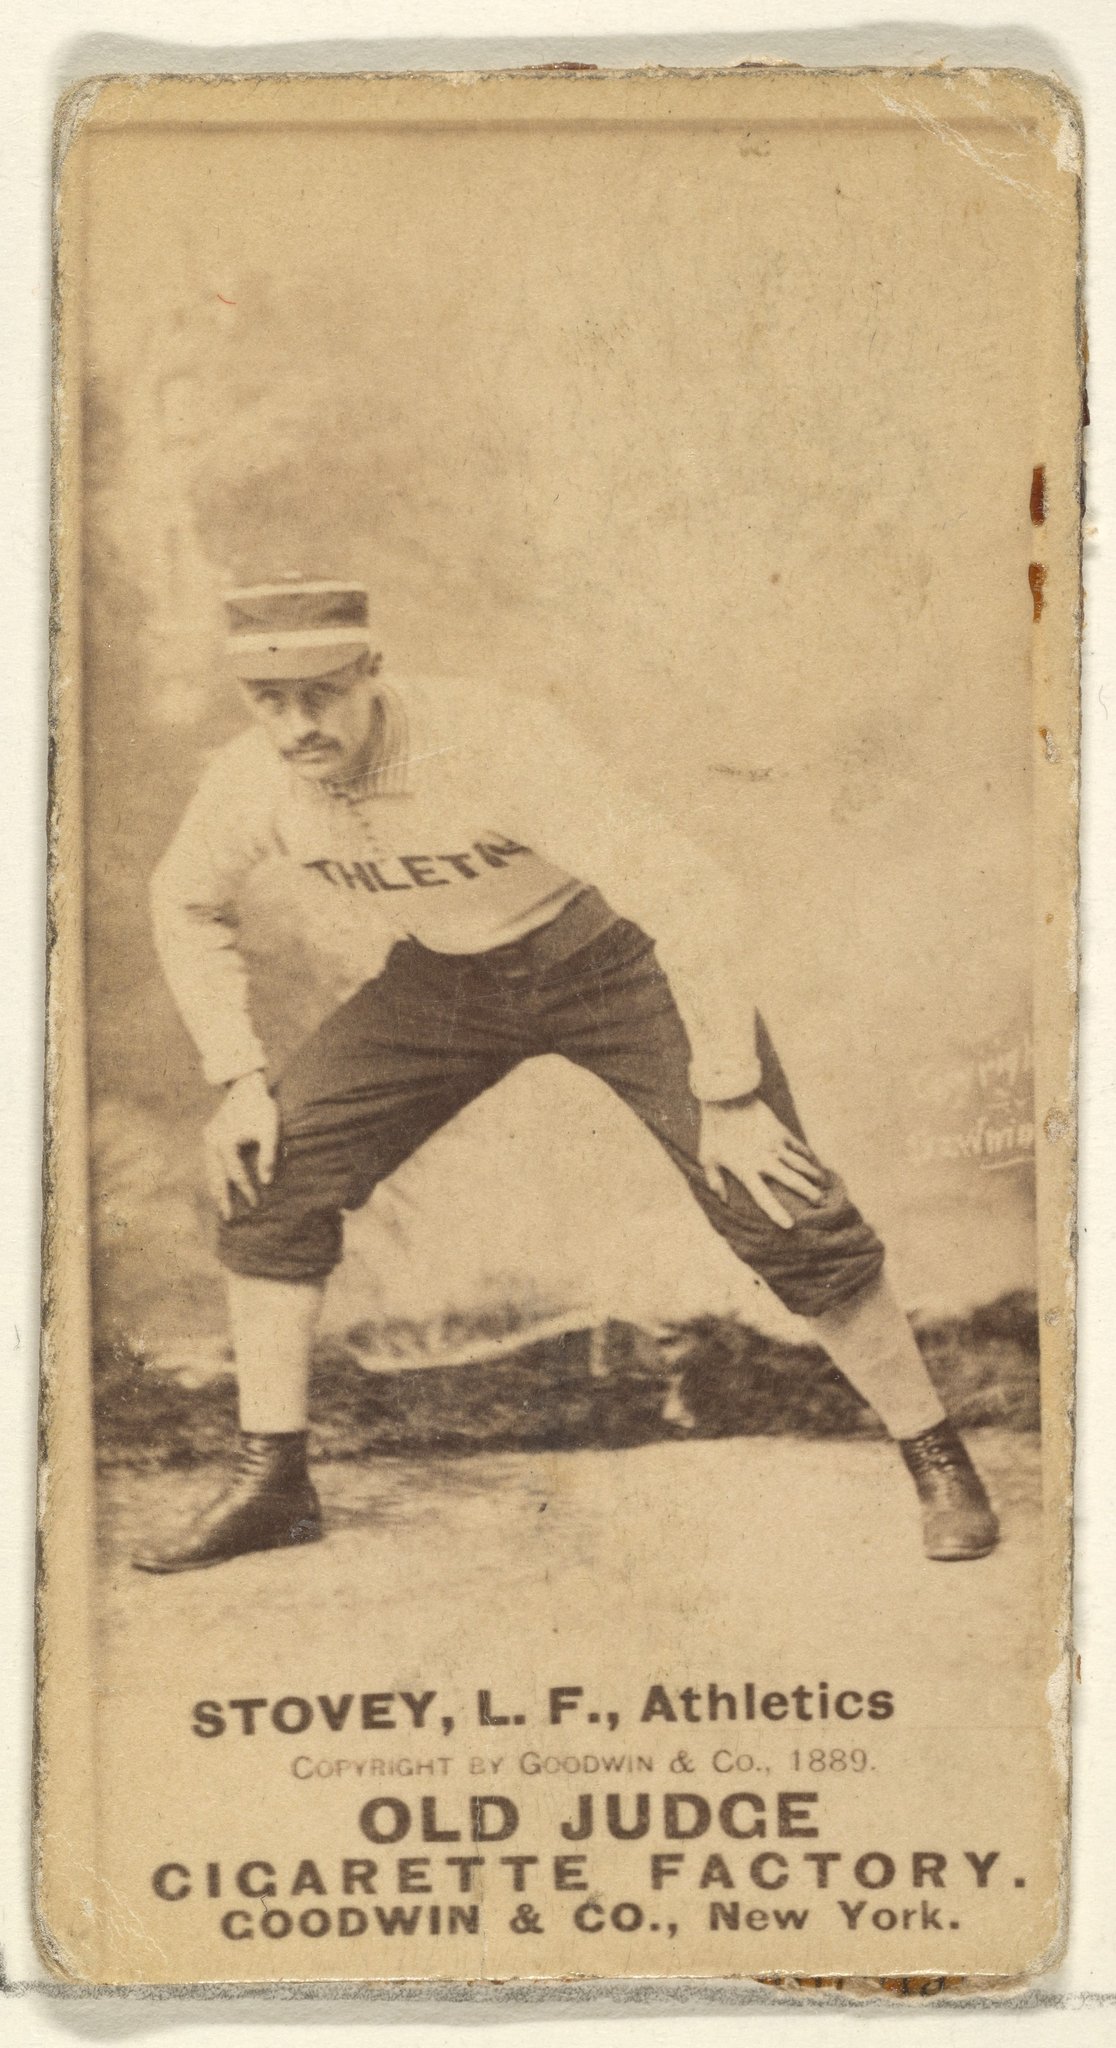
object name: baseball card, photograph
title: Stovey, Left Field, Philadelphia Athletics, from the Old Judge series (N172) for Old Judge Cigarettes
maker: goodwin & company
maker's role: publisher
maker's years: 1850-1950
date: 1889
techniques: albumen silver print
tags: men,portraits,baseball,athletes